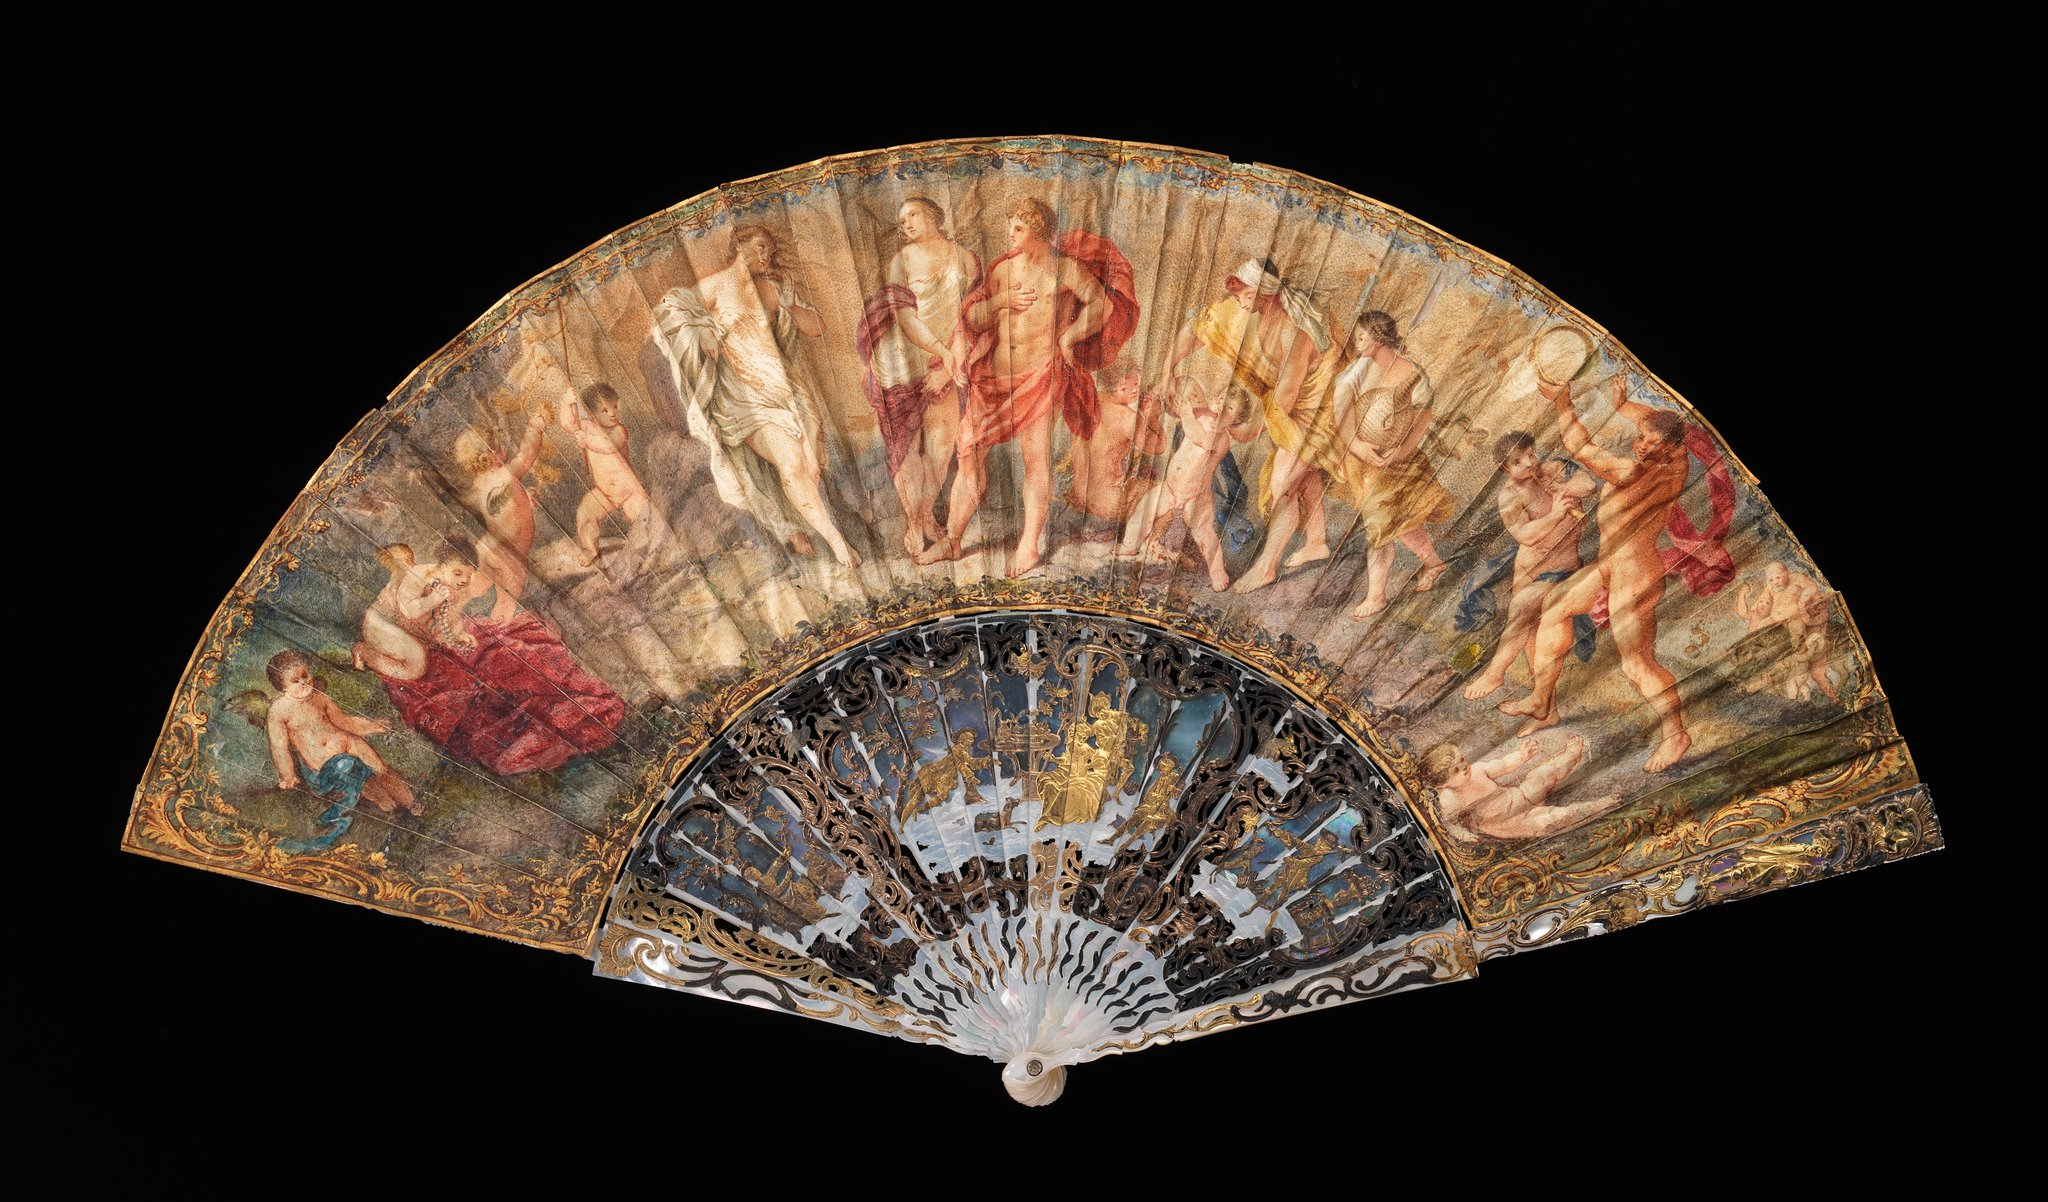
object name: fan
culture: italian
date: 1750-1770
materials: gouache, metal, mother of pearl, parchment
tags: men,women,putti